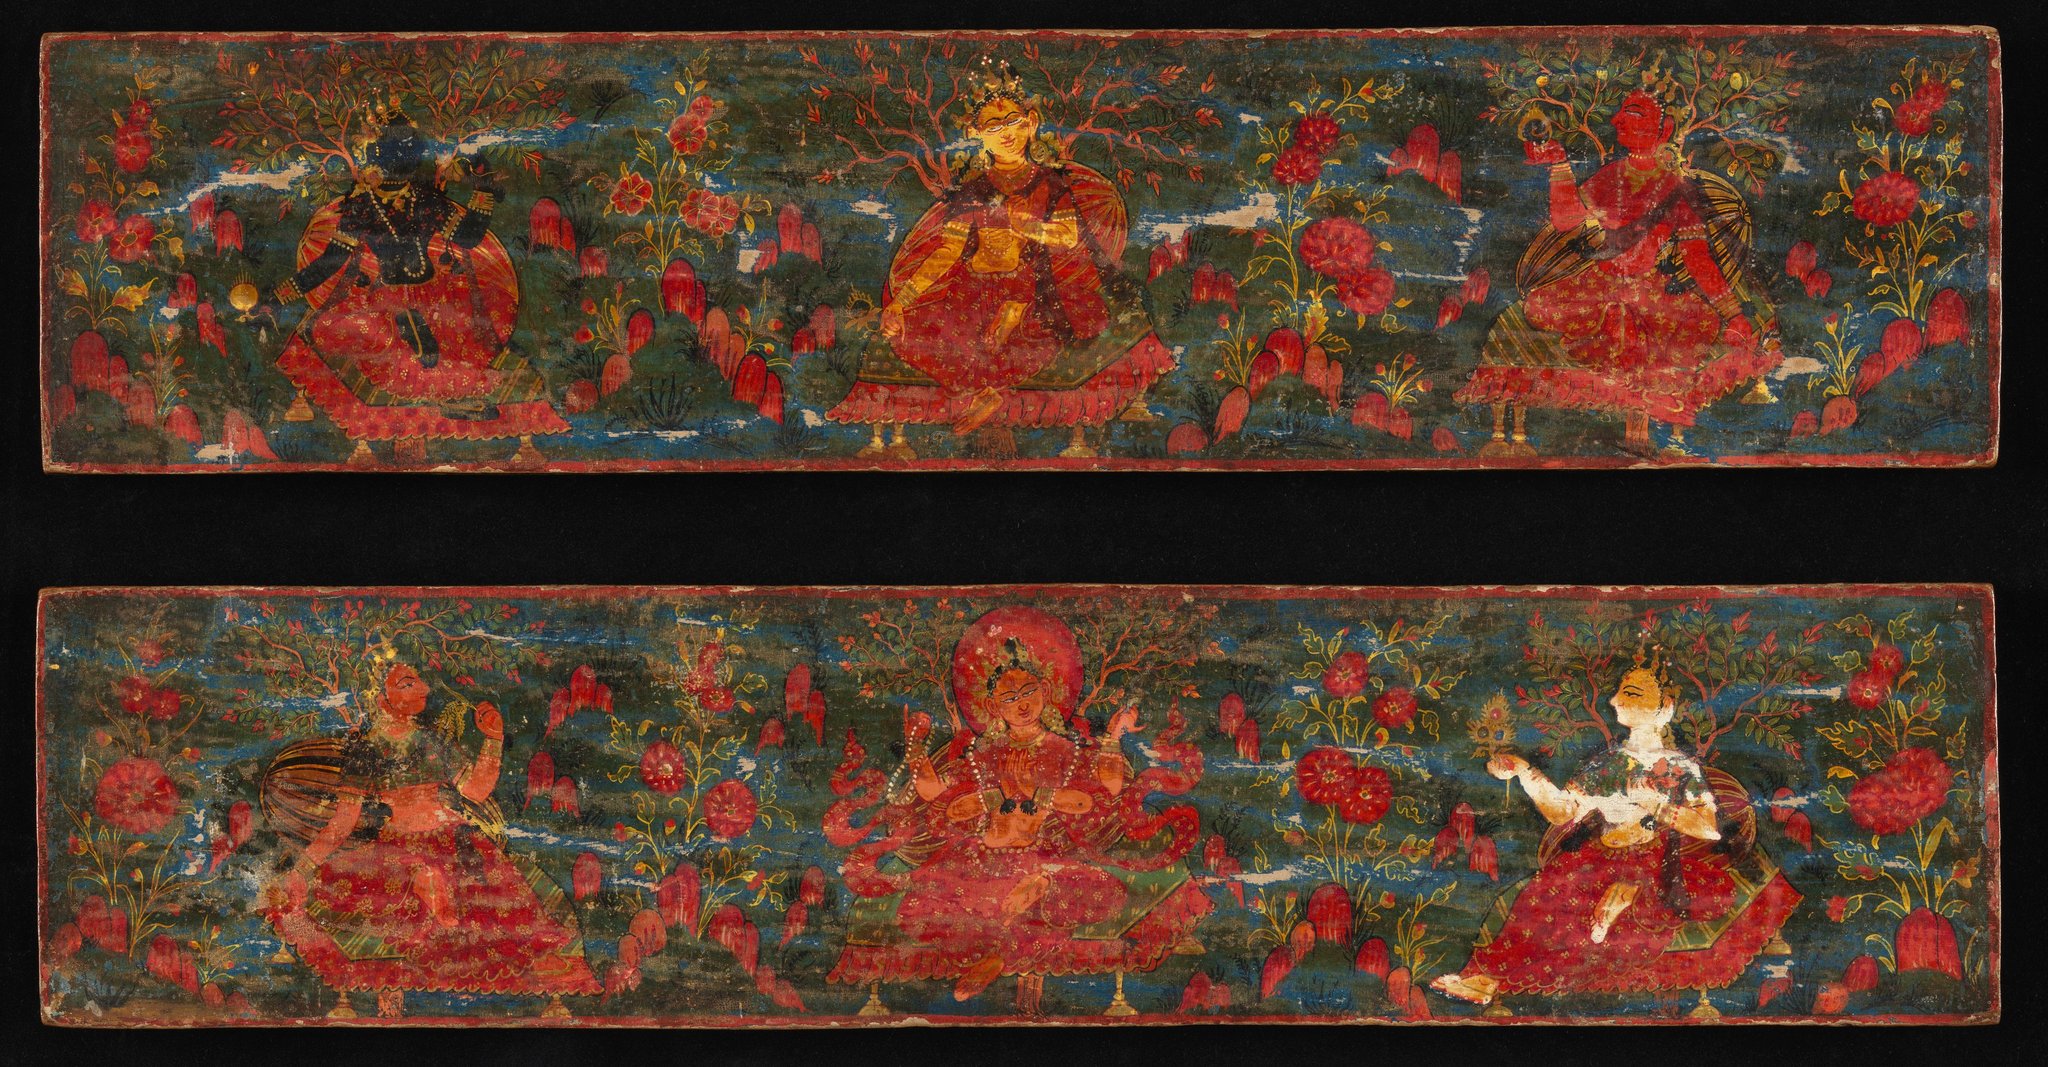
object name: book cover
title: Pair of Manuscript Covers with Goddesses Set in a Foliate Landscape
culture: nepali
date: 1601-1700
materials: wood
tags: flowers,goddess